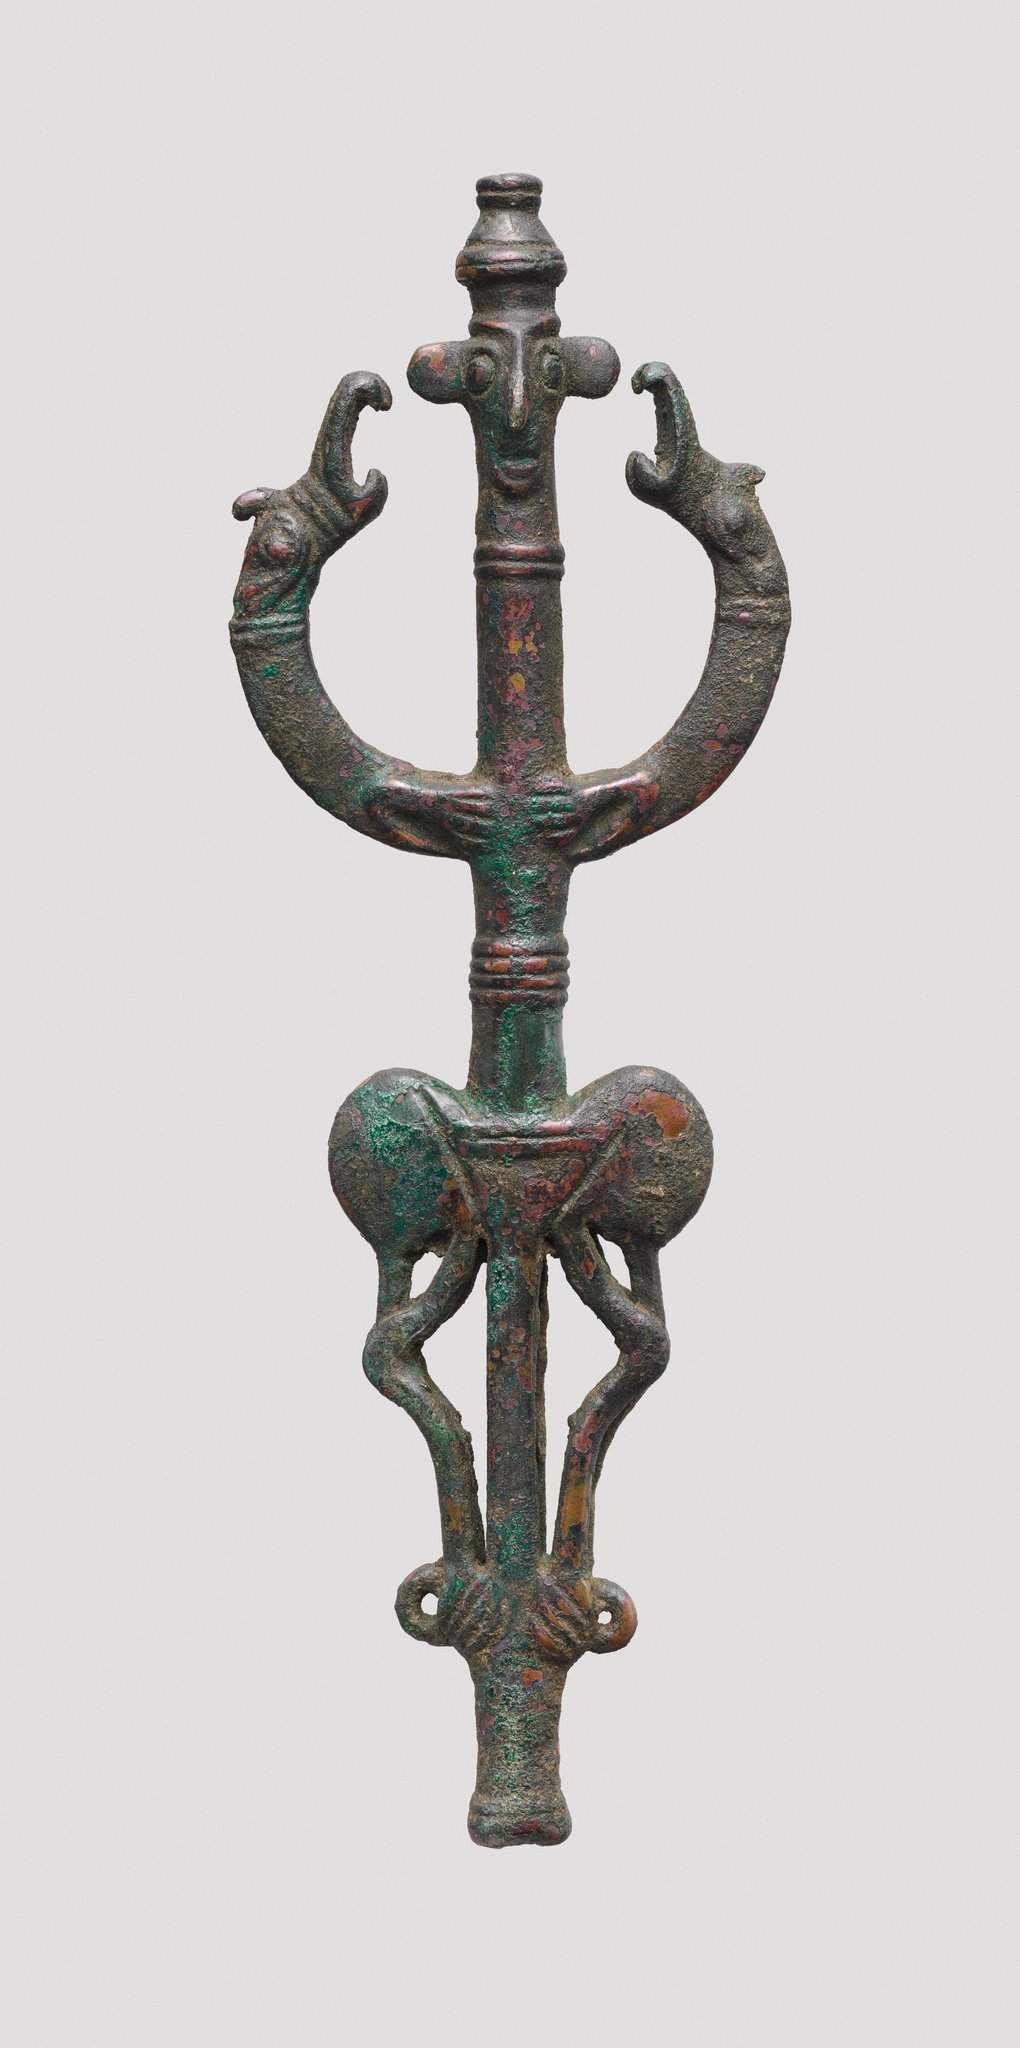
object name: sculpture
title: Master-of-animals standard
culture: iranian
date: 800-701 BCE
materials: bronze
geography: iran, probably from luristan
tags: animals